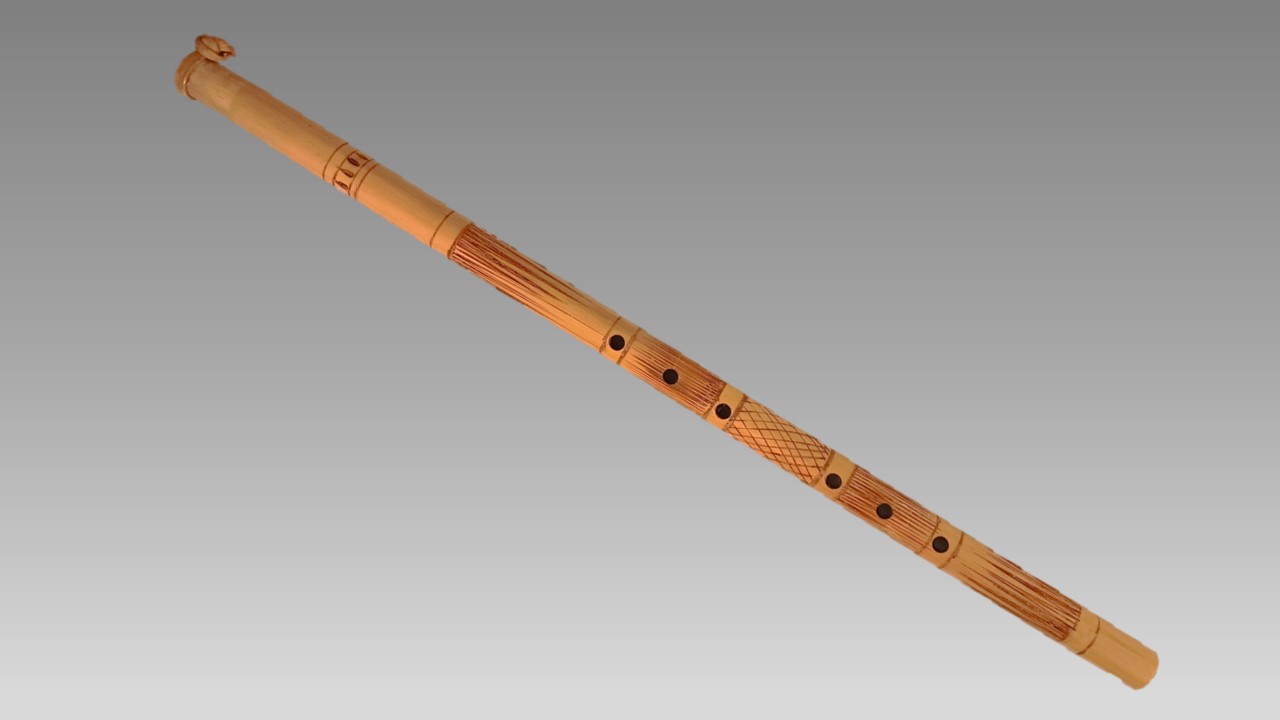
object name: suling pélog ring flute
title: Suling Pélog (ring flute)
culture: javanese, sunda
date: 1801-1900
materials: bamboo, rattan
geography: indonesia